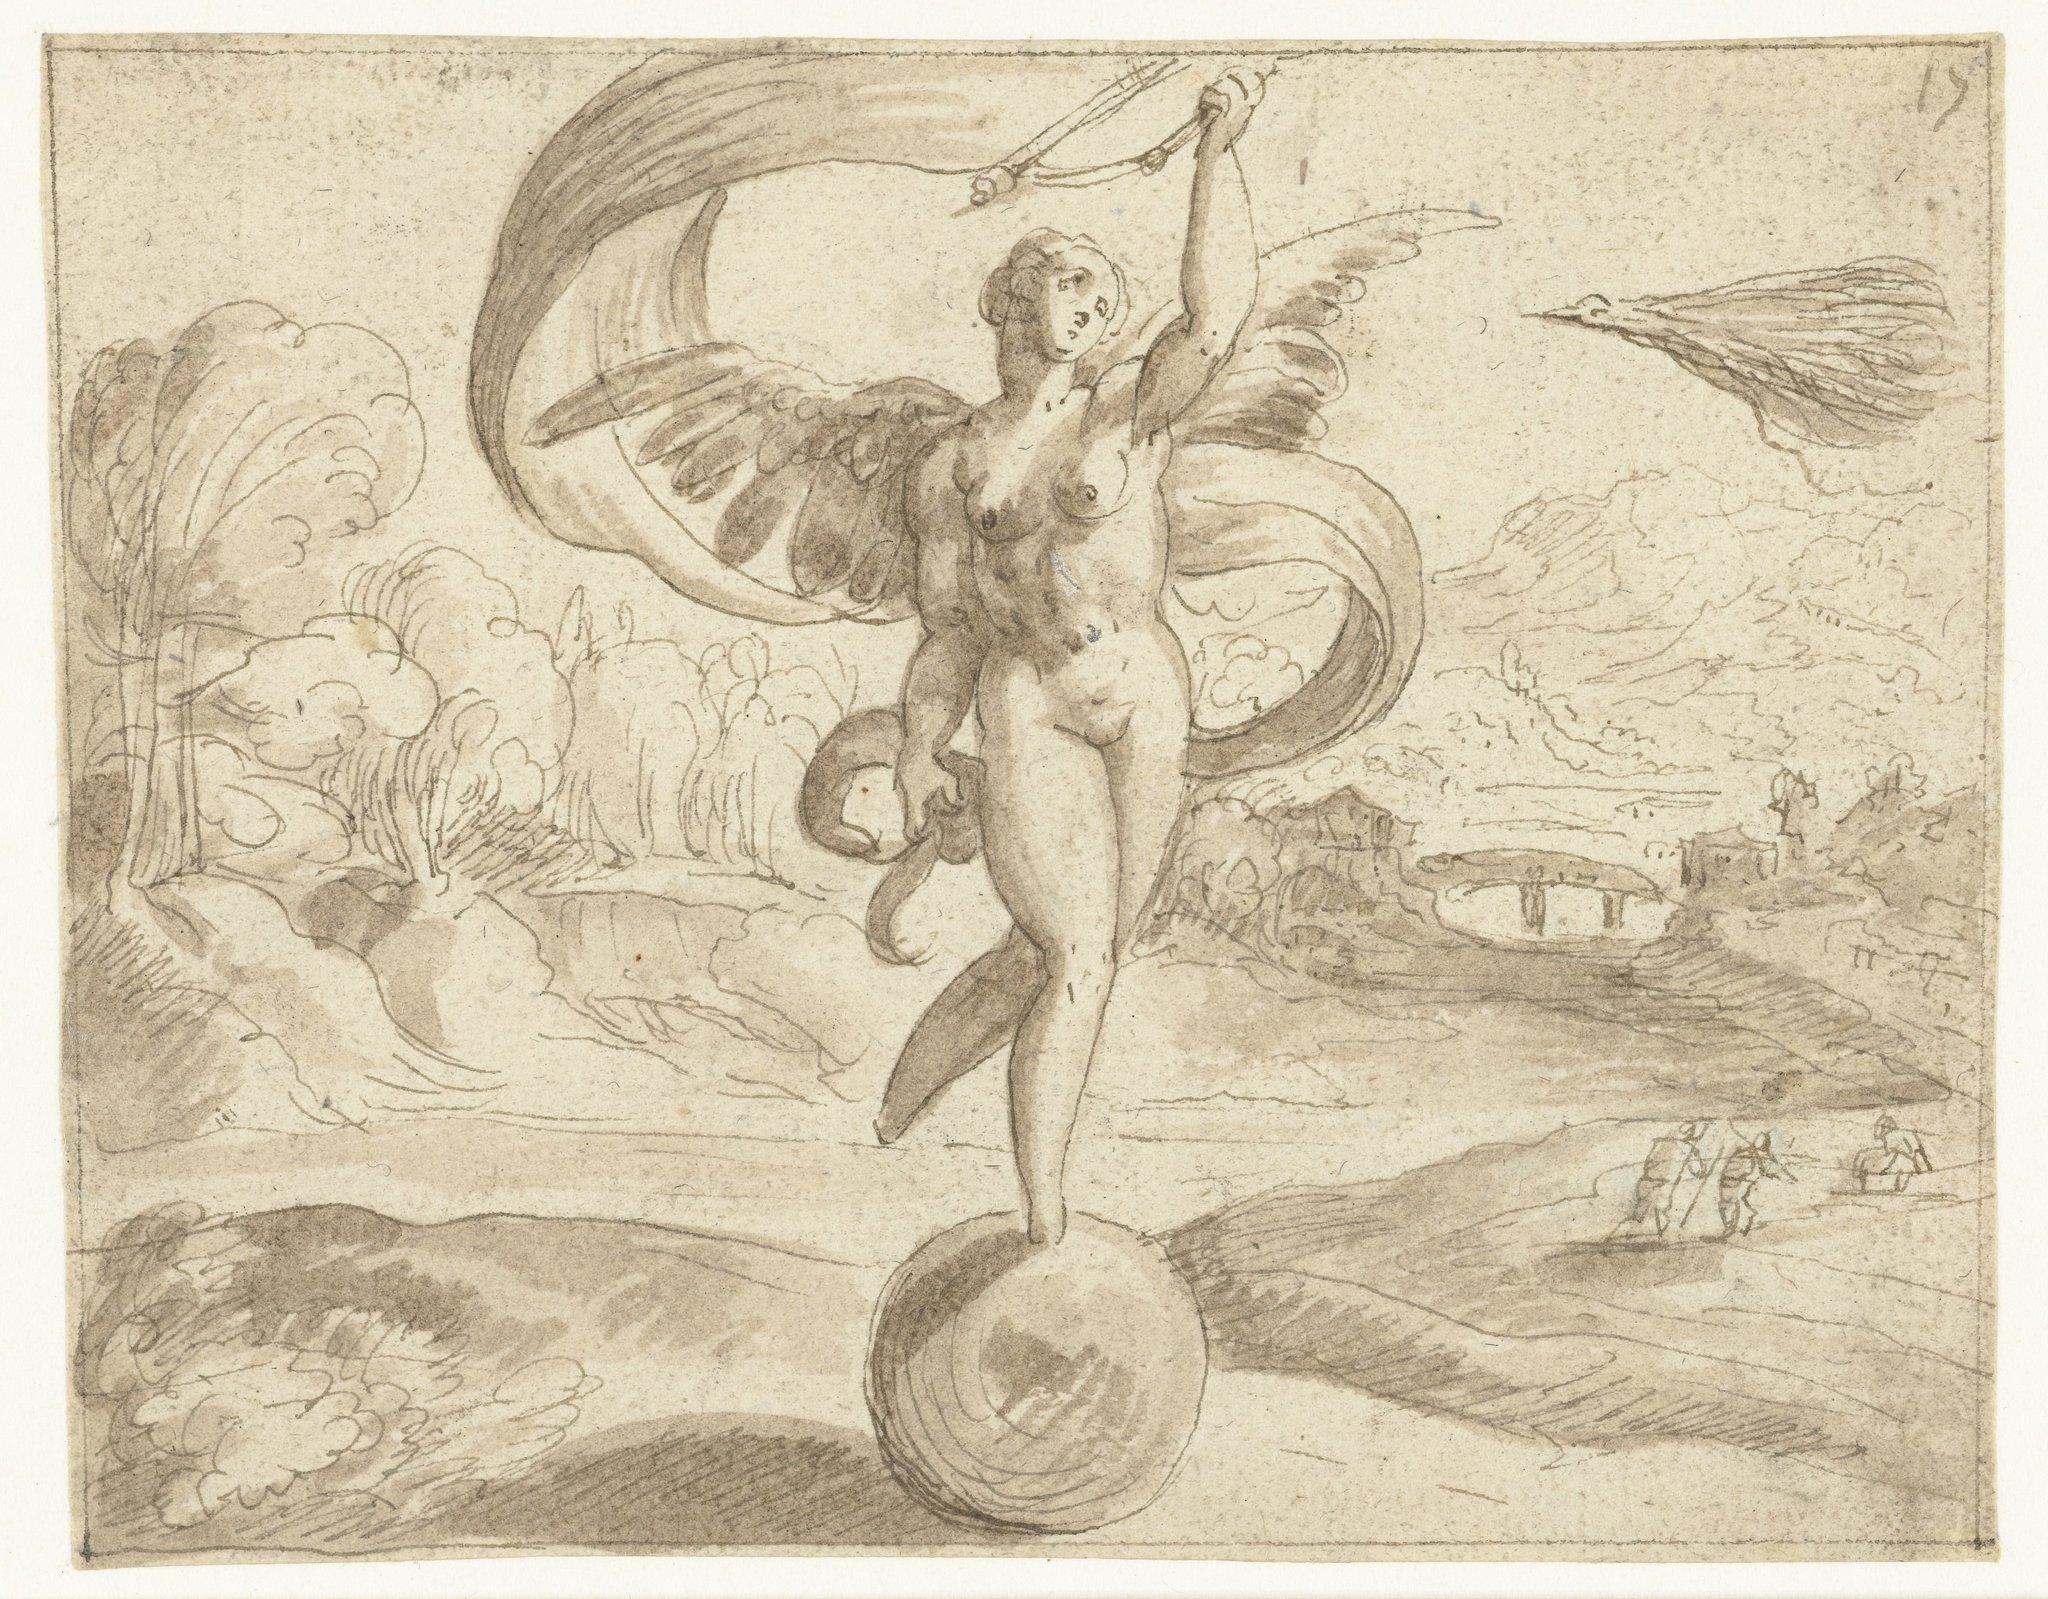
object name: drawing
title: Fortuna zonder voeten, staande op een bol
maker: jan snellinck (i)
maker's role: draughtsman, painter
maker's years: 1544-1638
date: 1575-1580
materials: ink, paper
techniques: brush, pen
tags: luck, fortune, lot; 'fato', 'fortuna', 'fortuna aurea', 'fortuna buona', 'fortuna pacifica overo clemente', 'sorte' (ripa) (+ nude)